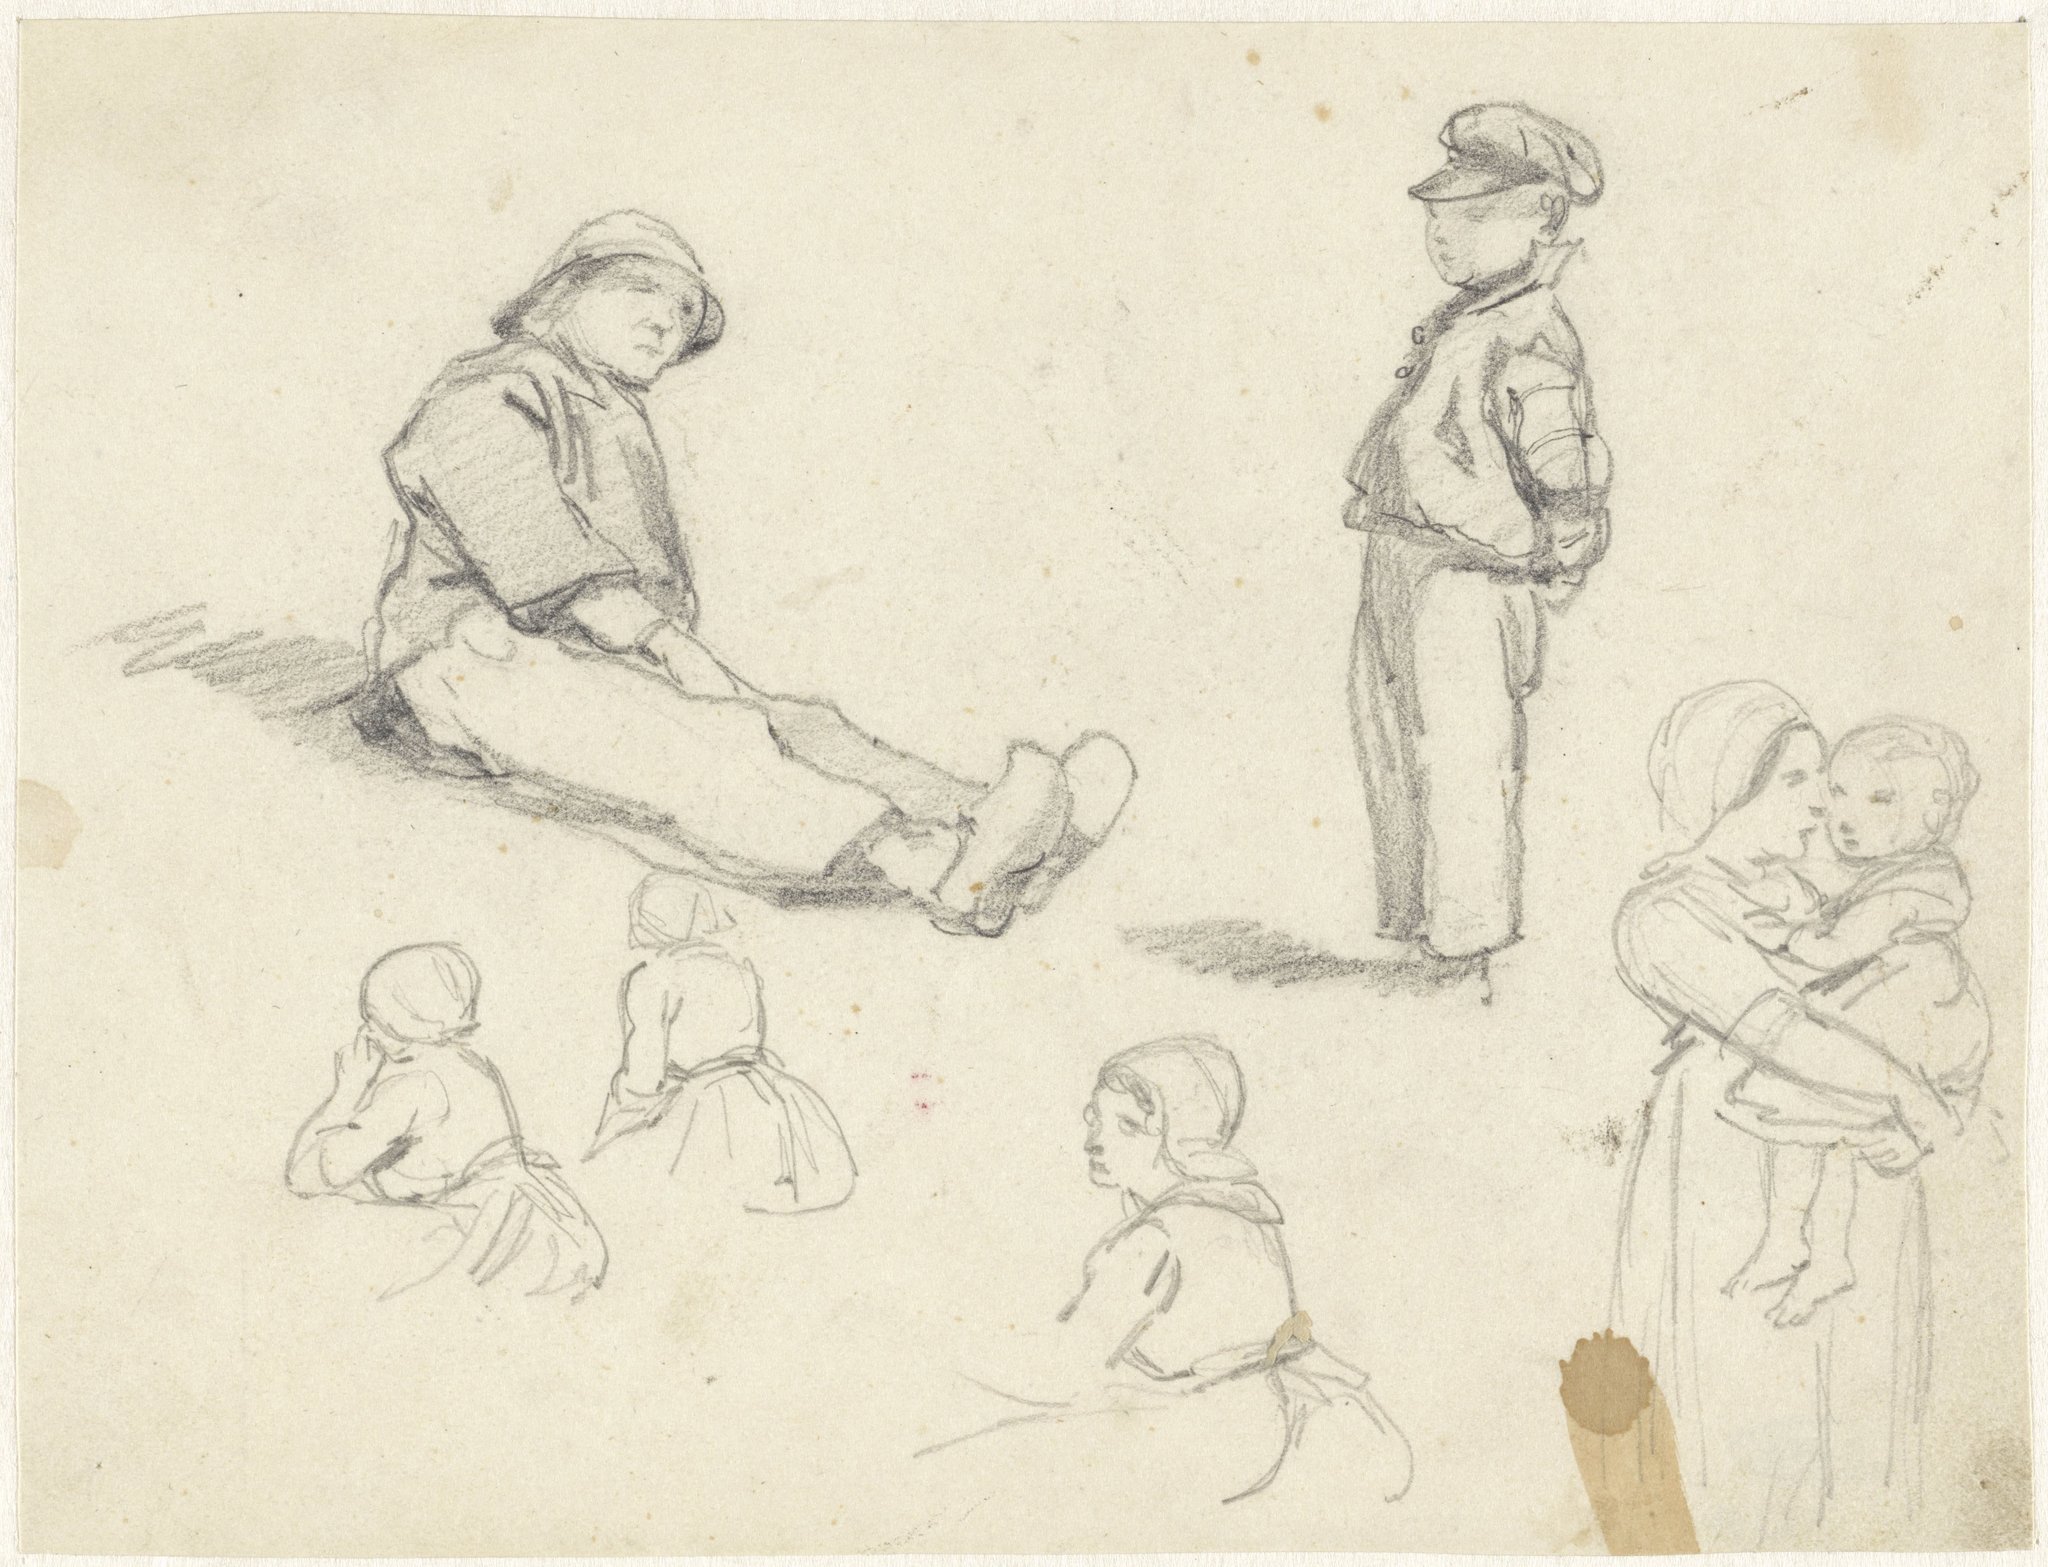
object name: drawing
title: Studieblad met schetsen van Scheveningse visserstypen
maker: charles rochussen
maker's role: draughtsman, painter, print maker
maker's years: 1814-1894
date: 1824-1894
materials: paper, pencil